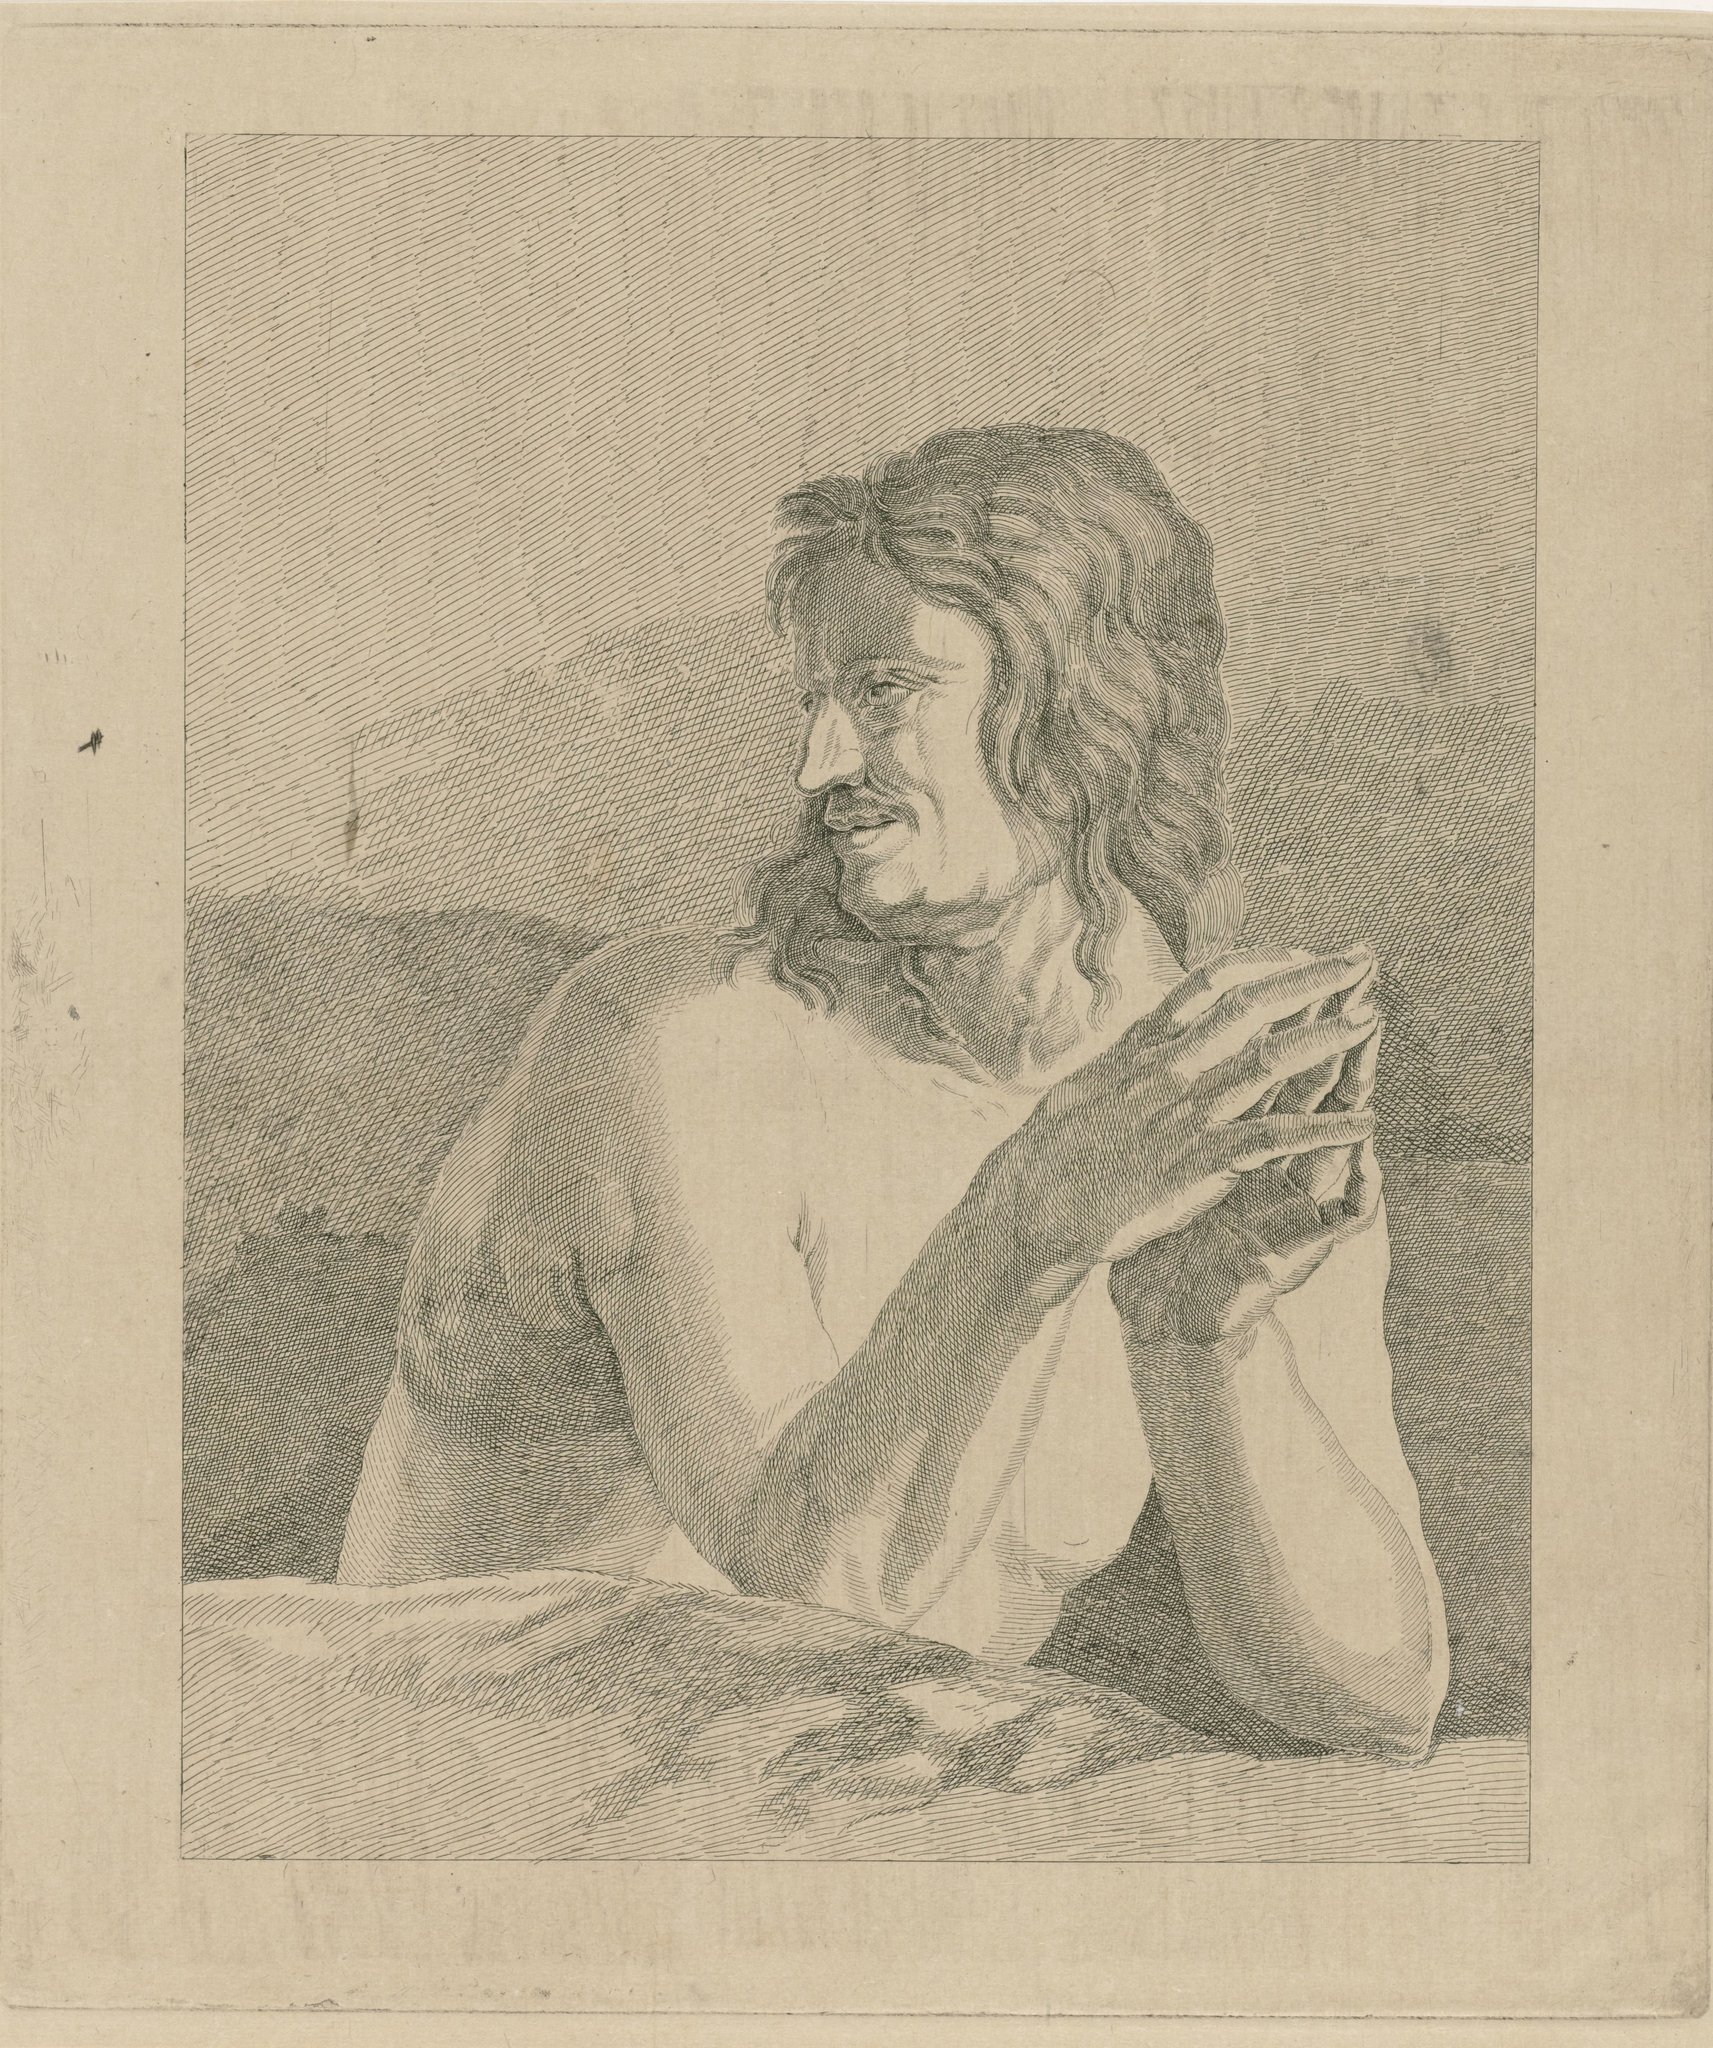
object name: print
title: Figuur uit het Laatste Oordeel van Lucas van Leyden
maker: pieter de mare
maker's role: print maker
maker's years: 1758-1796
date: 1768-1796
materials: paper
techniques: etching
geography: leiden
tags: hands folded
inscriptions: collector's mark: Lugt 240